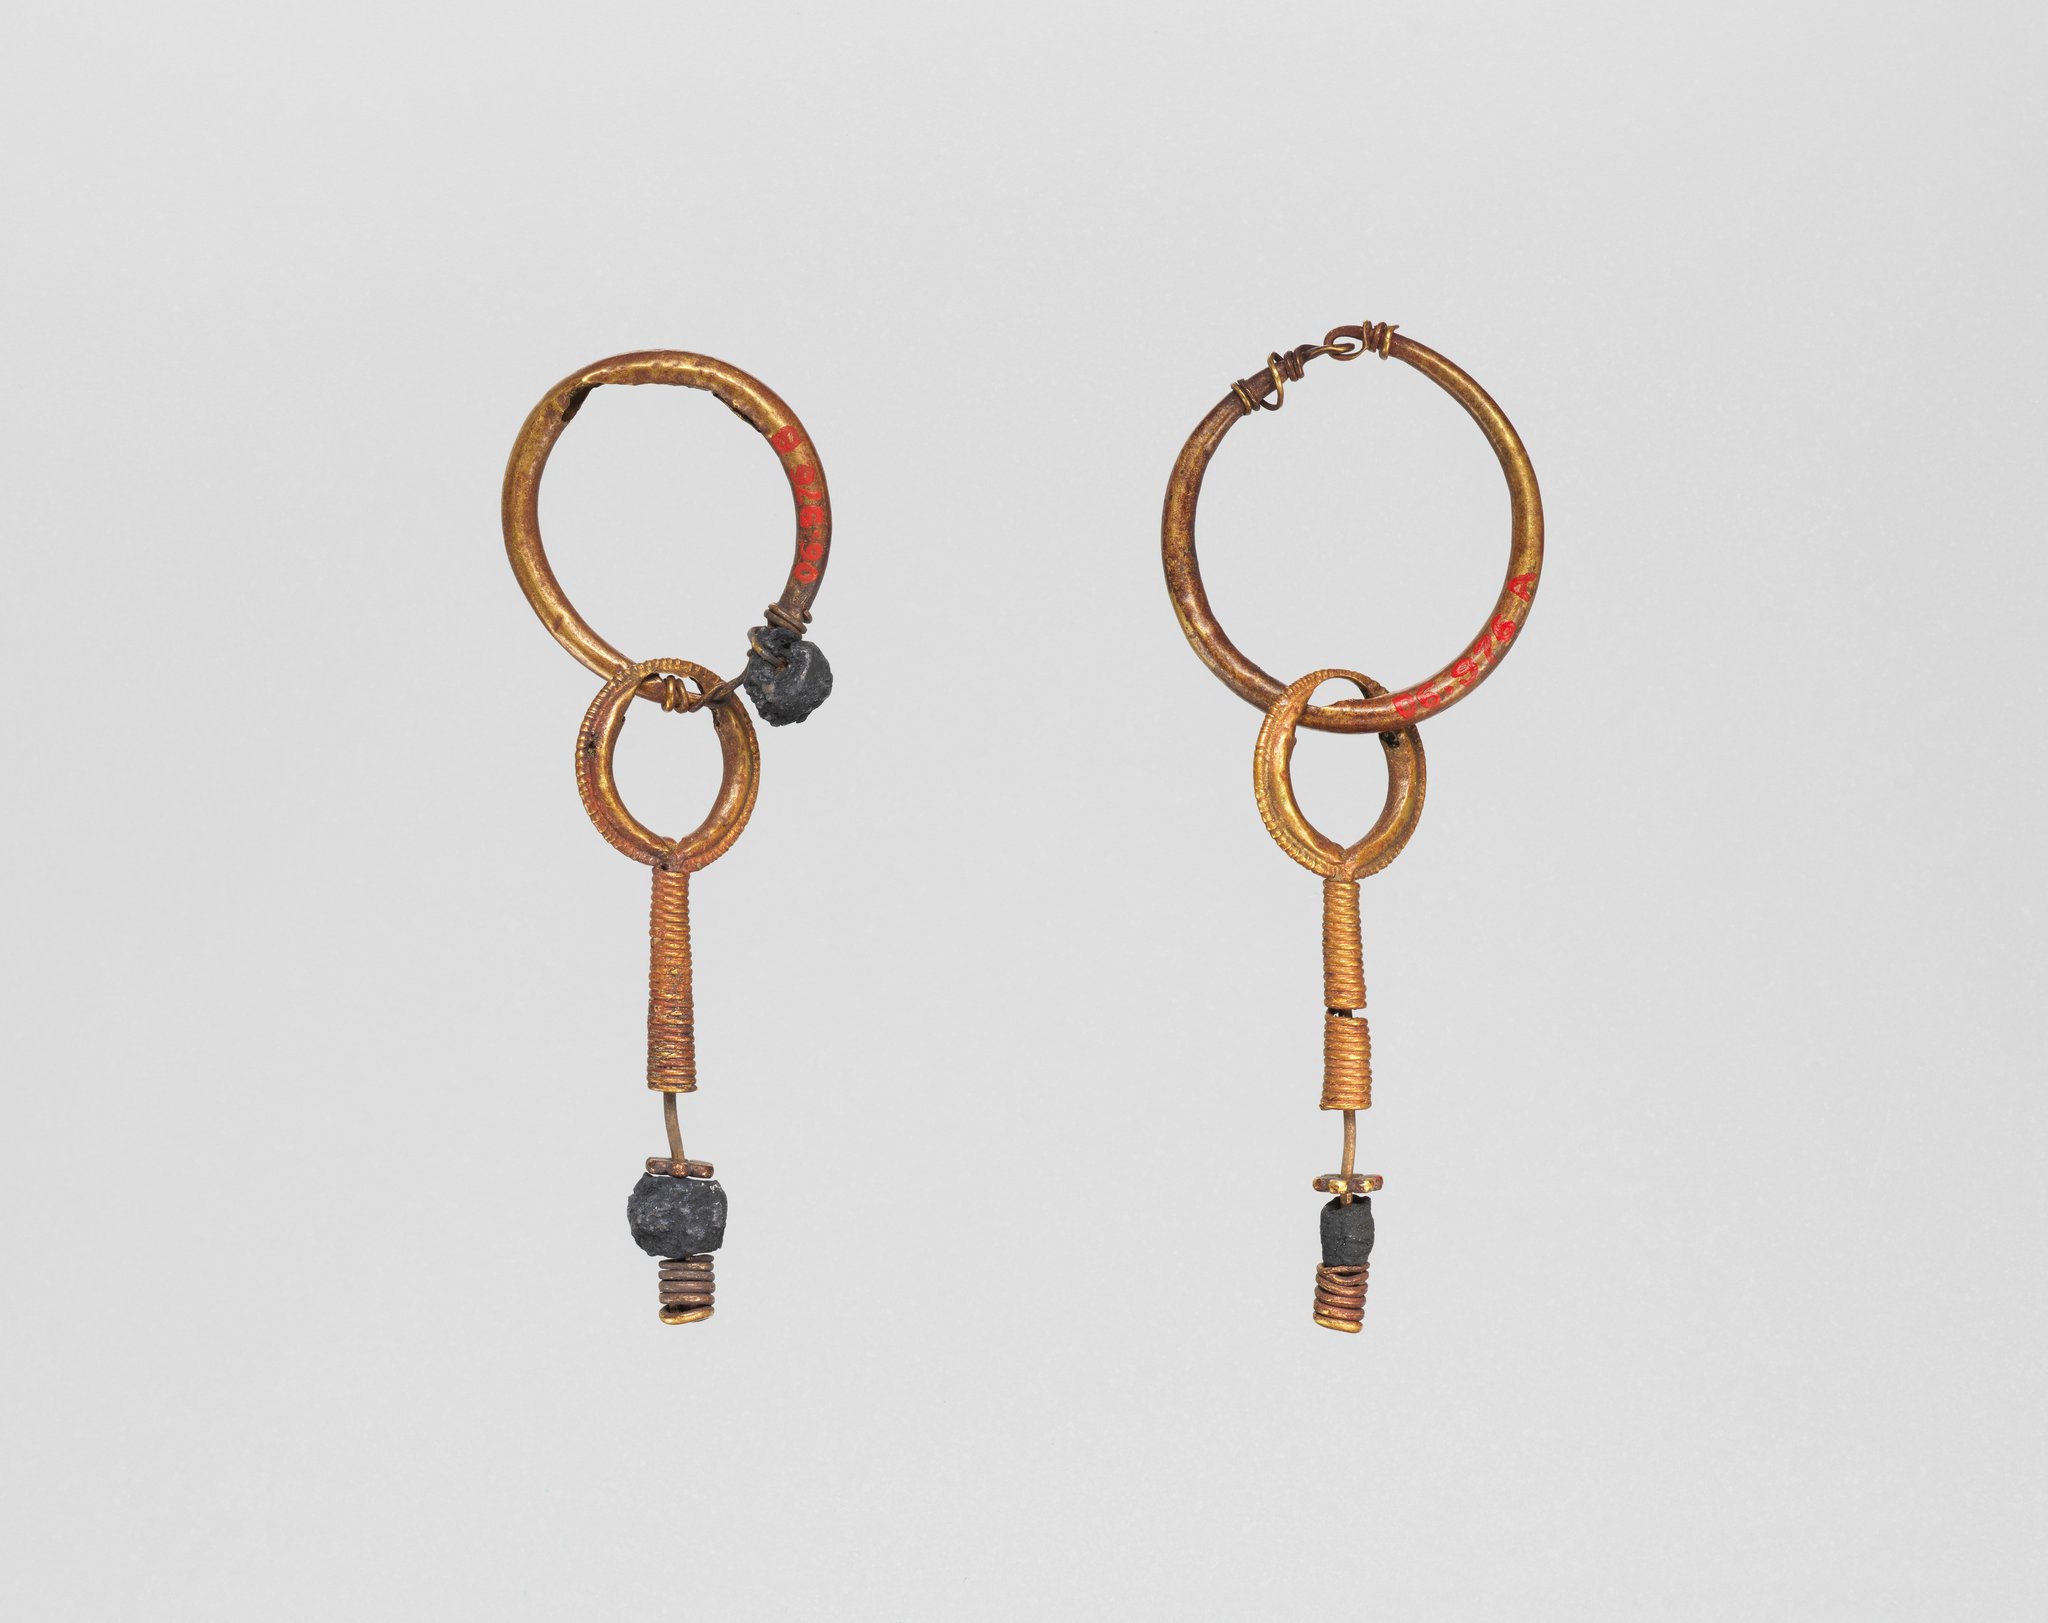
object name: earring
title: Pair of Earrings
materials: gold, silver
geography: egypt